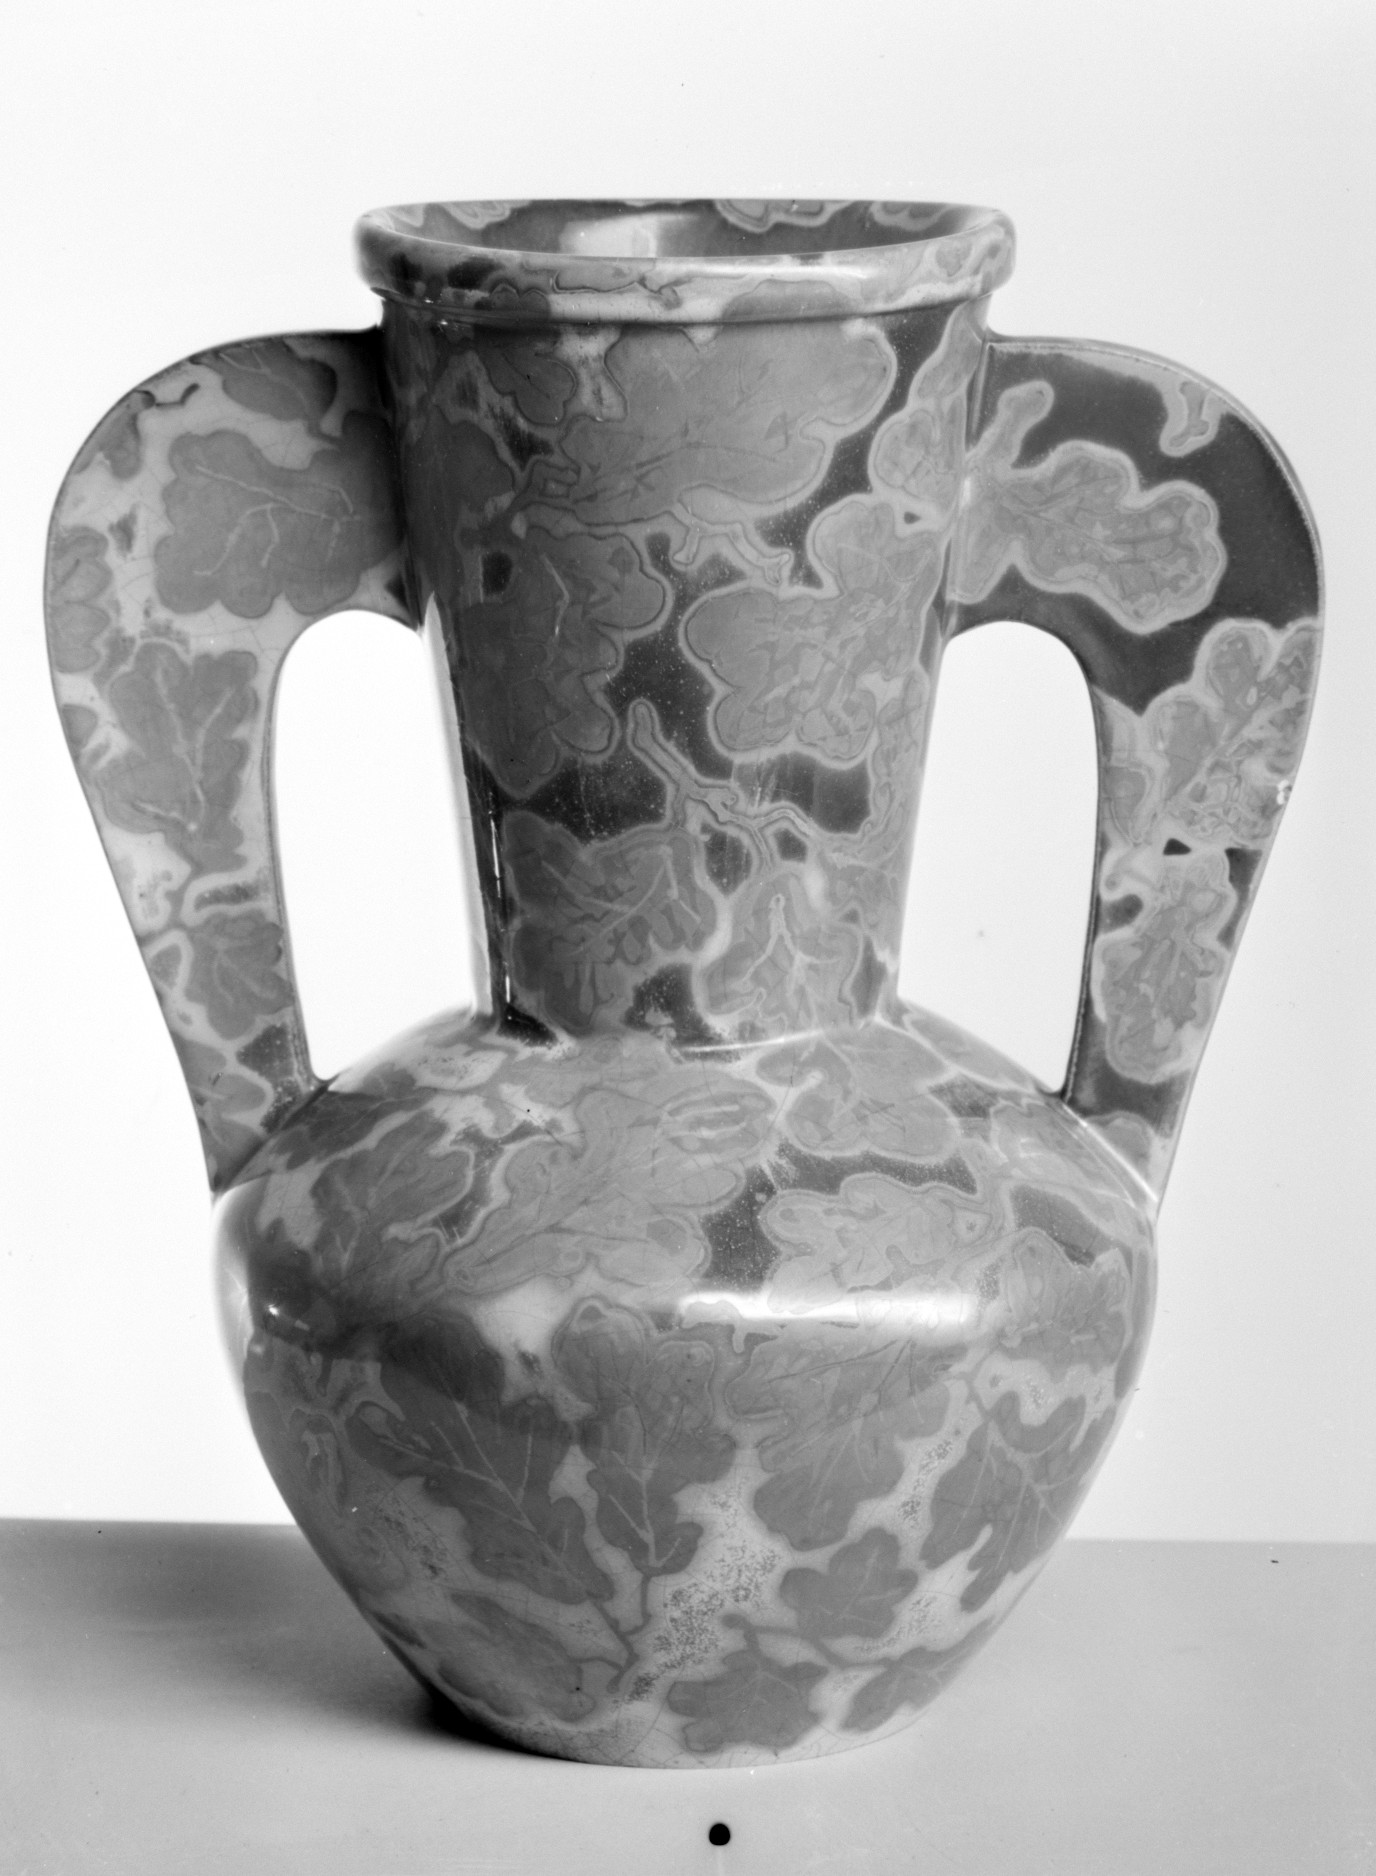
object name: vase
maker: clément massier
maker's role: maker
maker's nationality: french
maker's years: 1844-1917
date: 1889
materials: earthenware